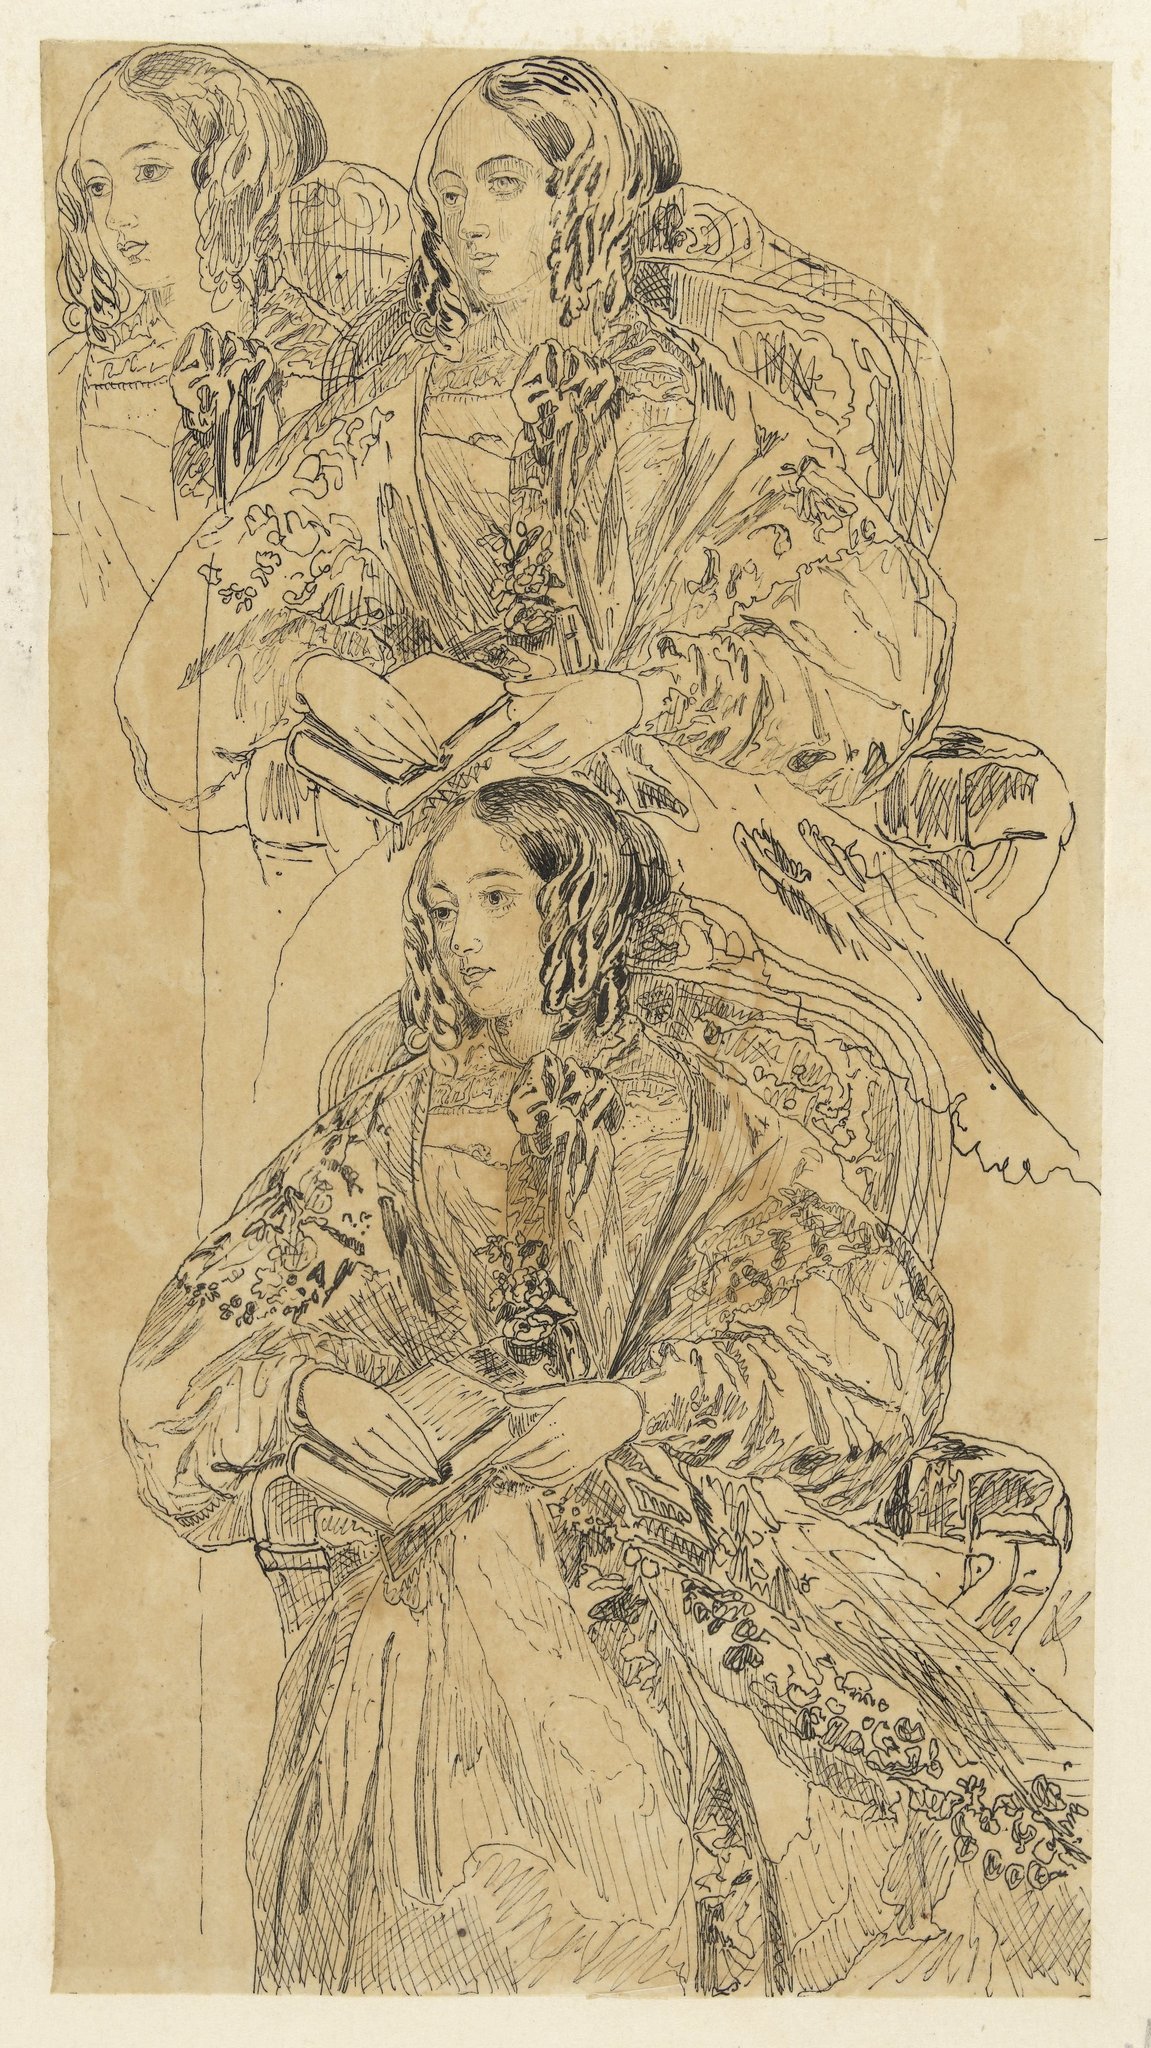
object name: drawing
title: Studieblad met zittende dame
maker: rodolphe bresdin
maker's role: draughtsman, print maker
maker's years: 1822-1885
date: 1832-1885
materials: ink, paper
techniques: pen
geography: france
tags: sitting figure - aa - female human figure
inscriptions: inscription: ‘Étude pour une Illustration (?)’